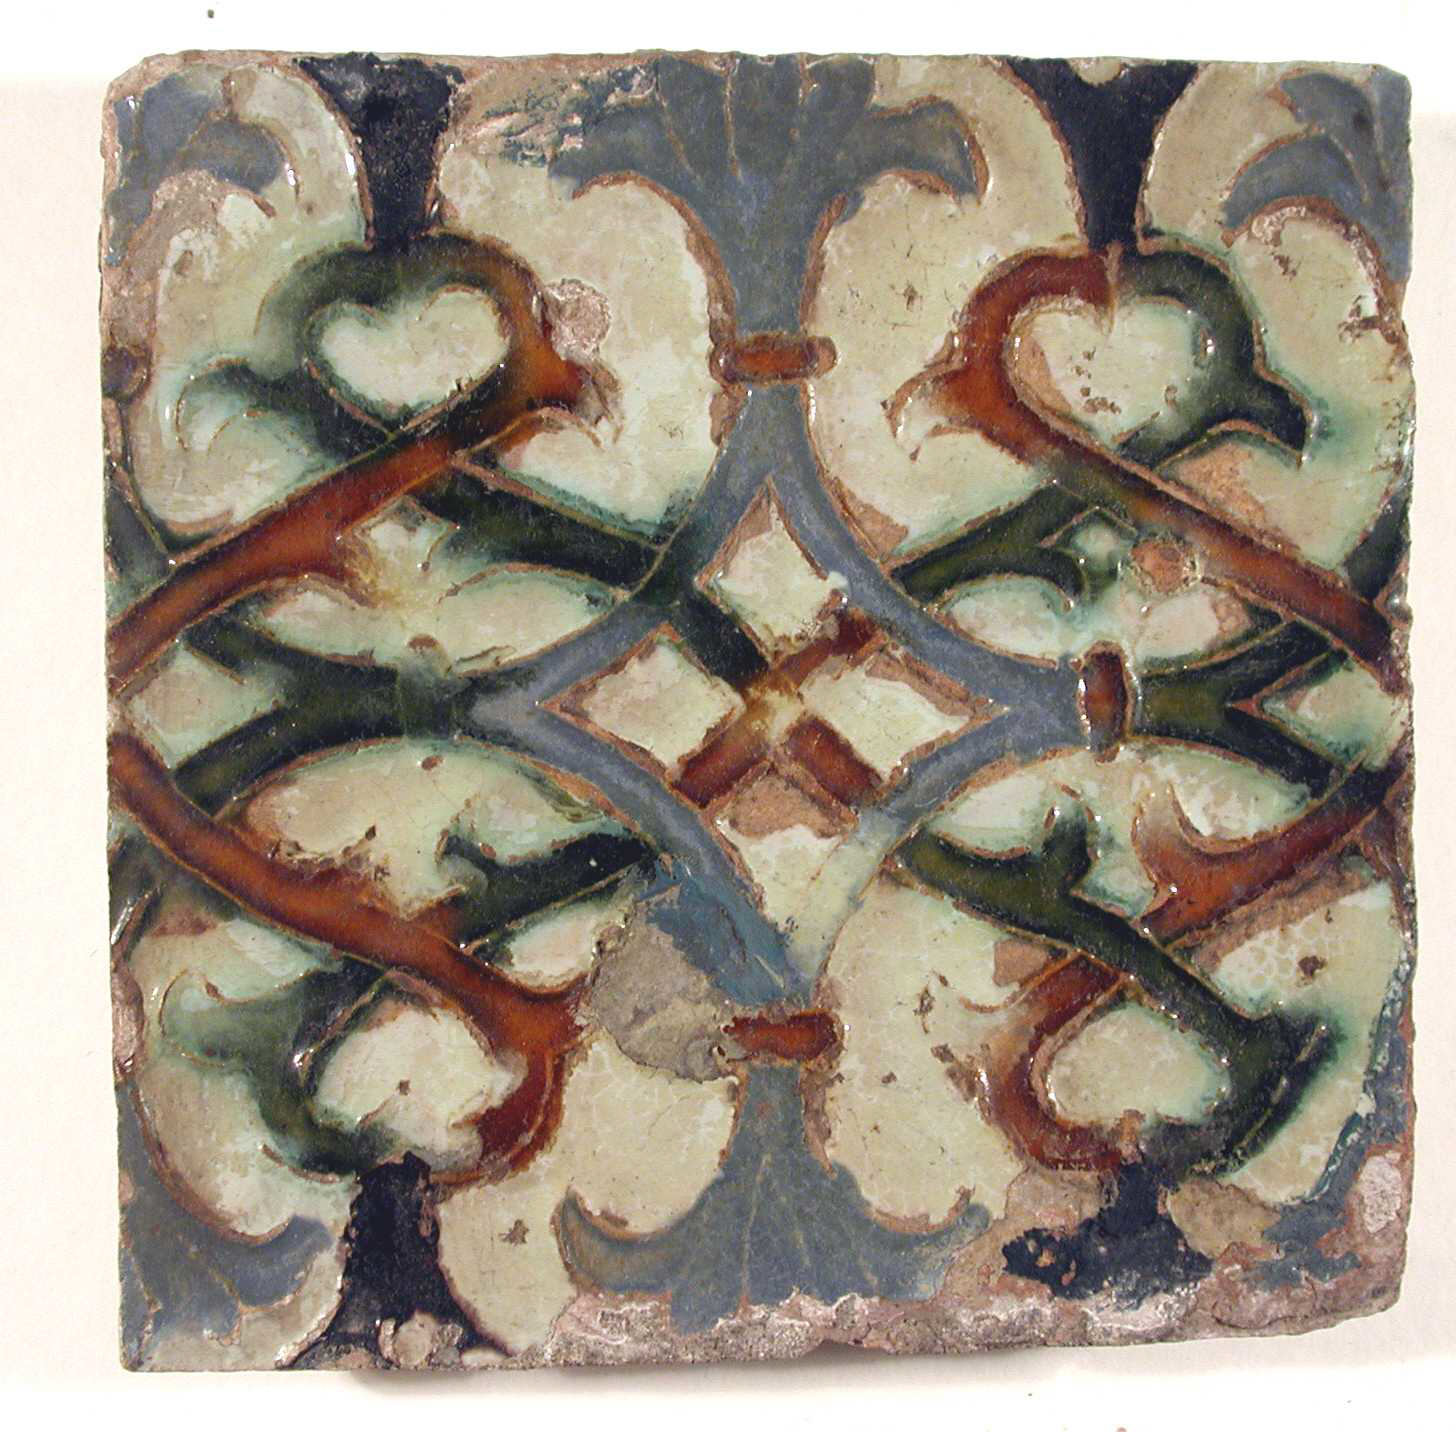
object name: tile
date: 1501-1700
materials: earthenware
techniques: glazing